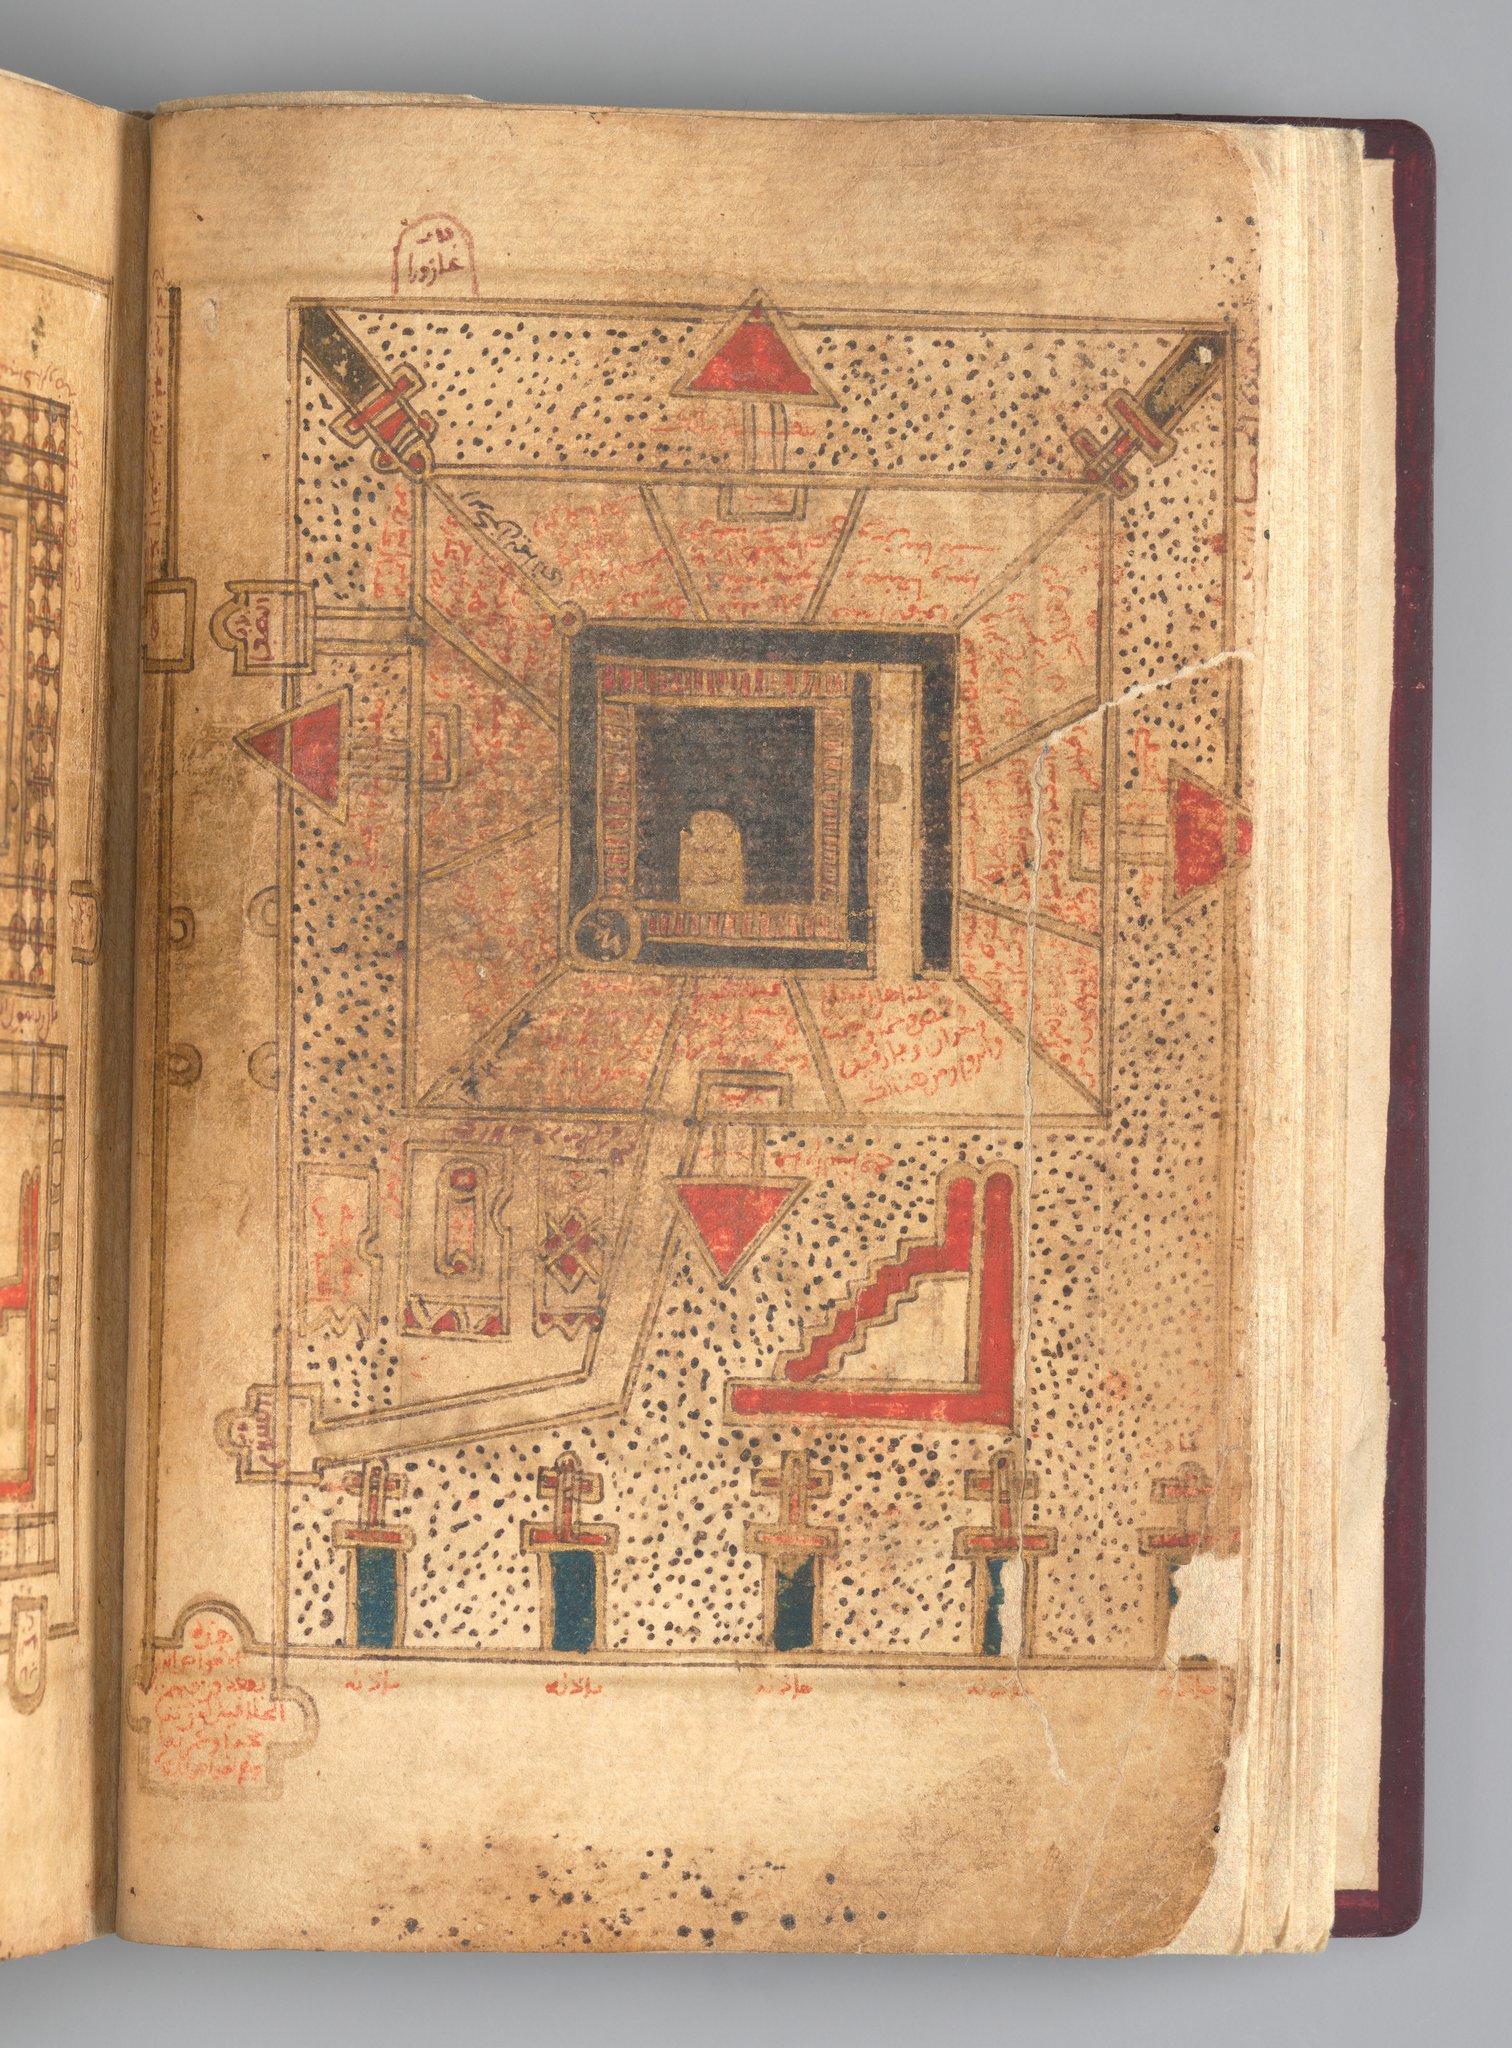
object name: illustrated manuscript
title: Dala'il al-Khayrat Prayer Book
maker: muhammad bin ahmad bin 'abd al-rahman al-riyahi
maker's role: calligrapher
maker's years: 1600-1650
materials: gilt, gold, ink, paper, watercolor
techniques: bookbinding, tooling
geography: algeria